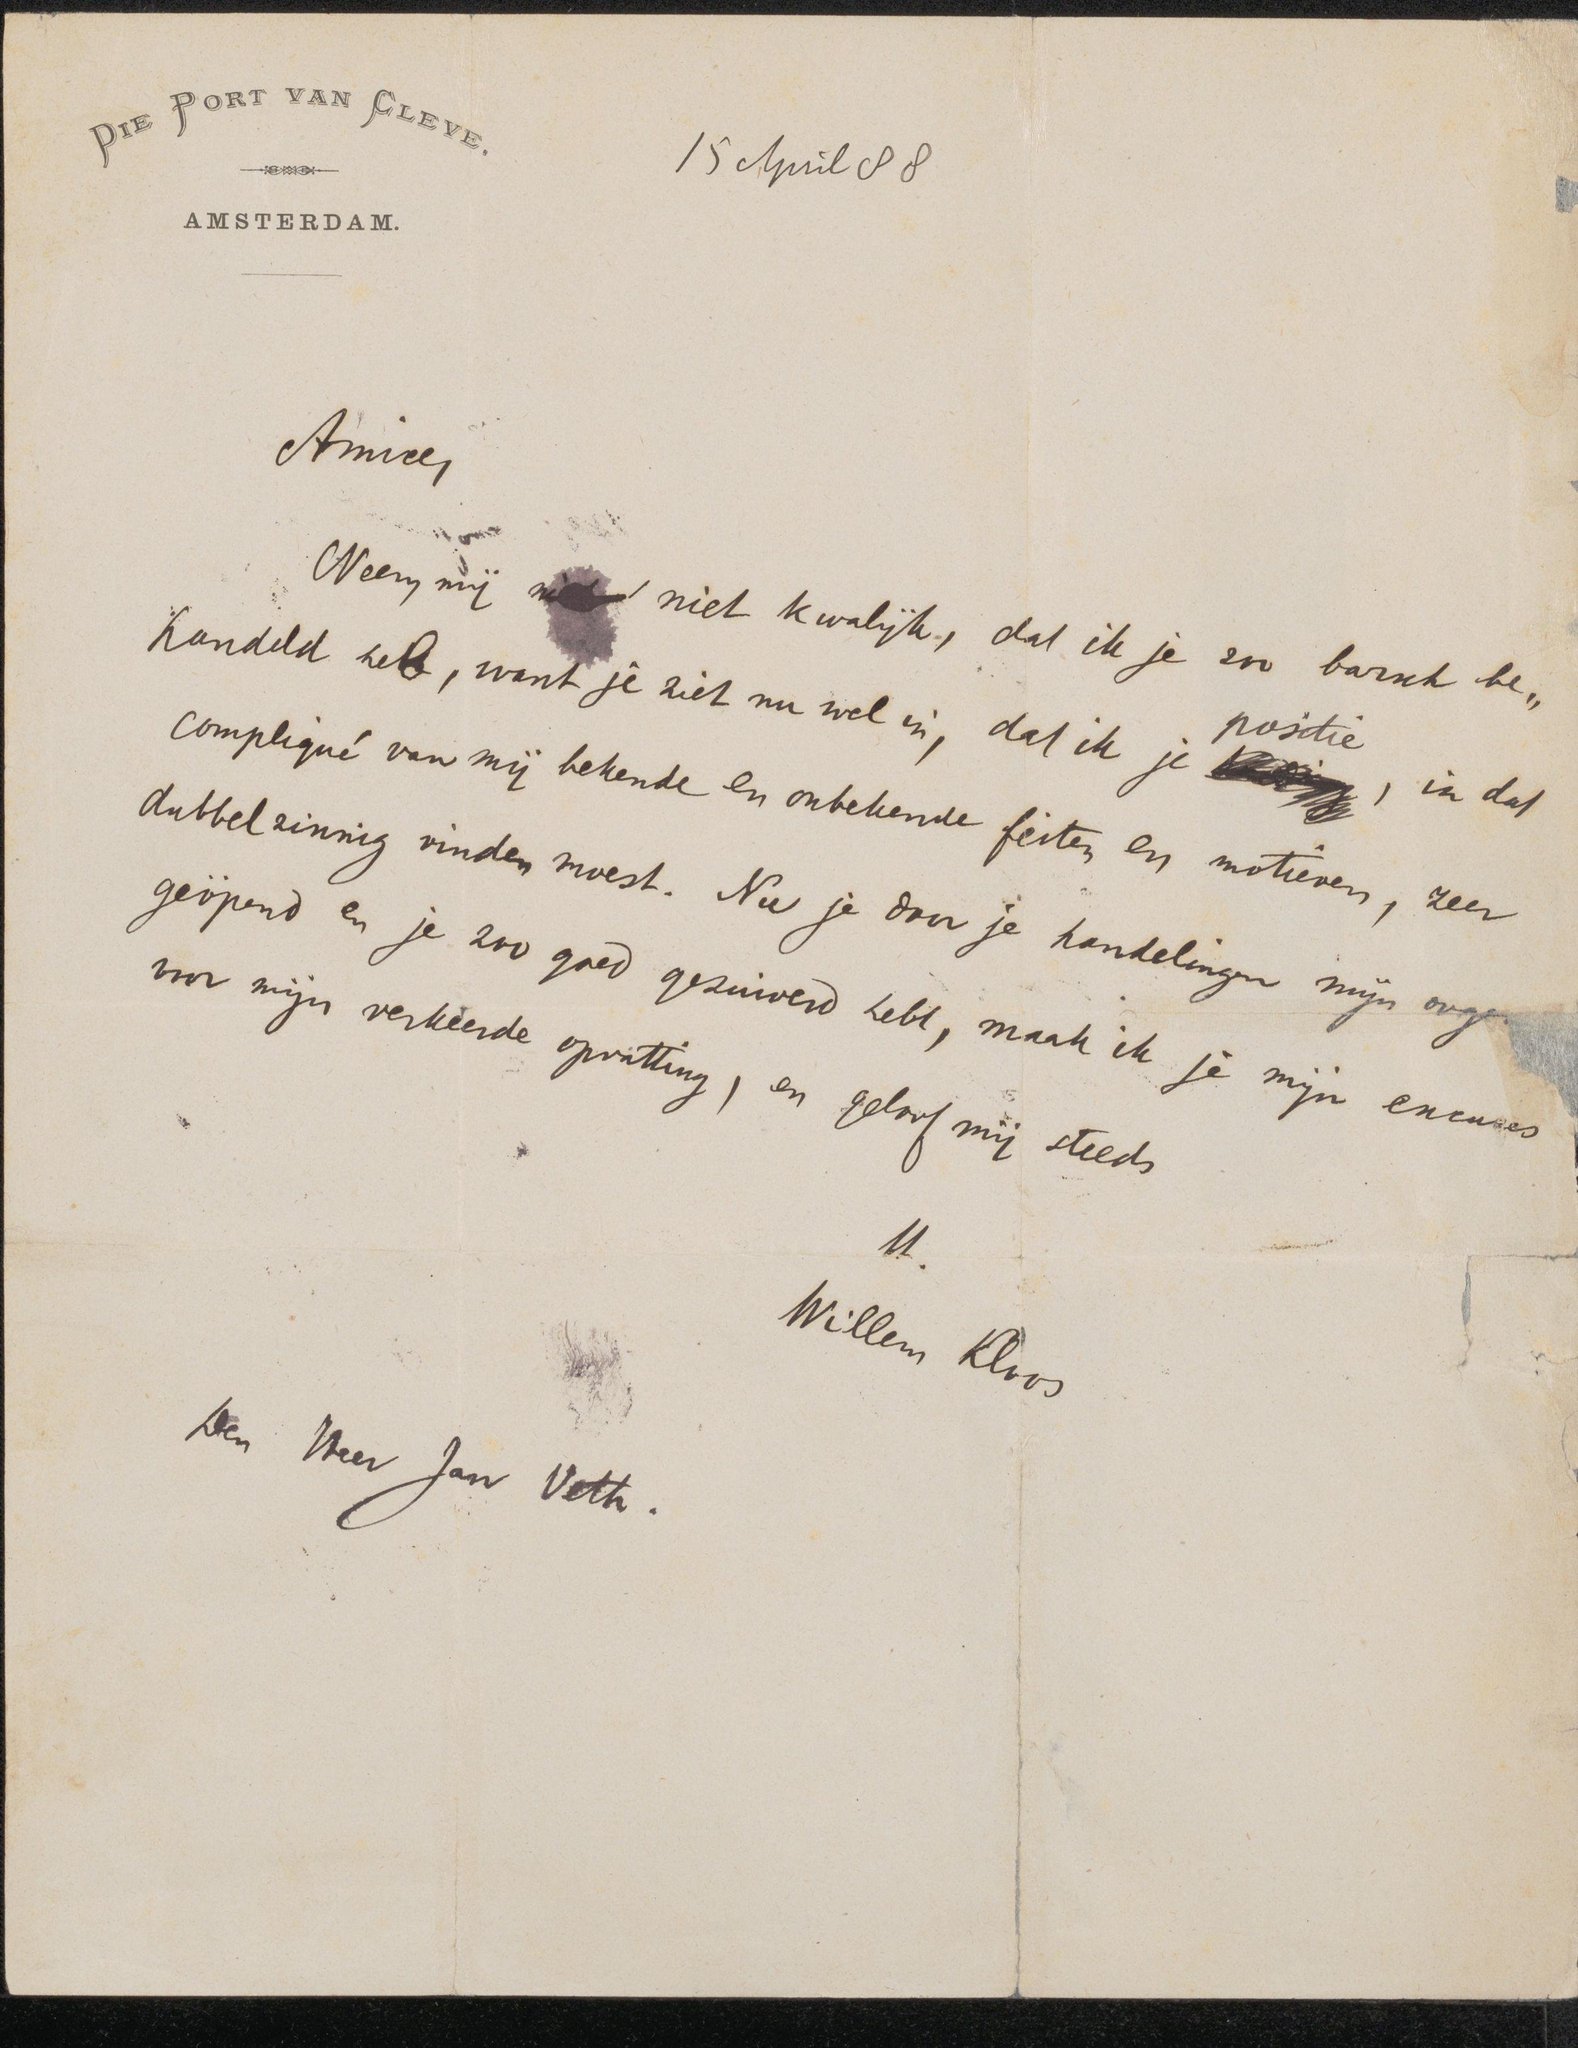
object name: letter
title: Brief aan Jan Veth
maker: willem kloos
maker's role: dichter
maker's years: 1859-1938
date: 1888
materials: ink, paper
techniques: pen, printing, writing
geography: amsterdam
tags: dordrecht, amsterdam, painter, print maker, draughtsman, designer, jan veth, passions, emotions, affections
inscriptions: collector's mark: ‘RPK’